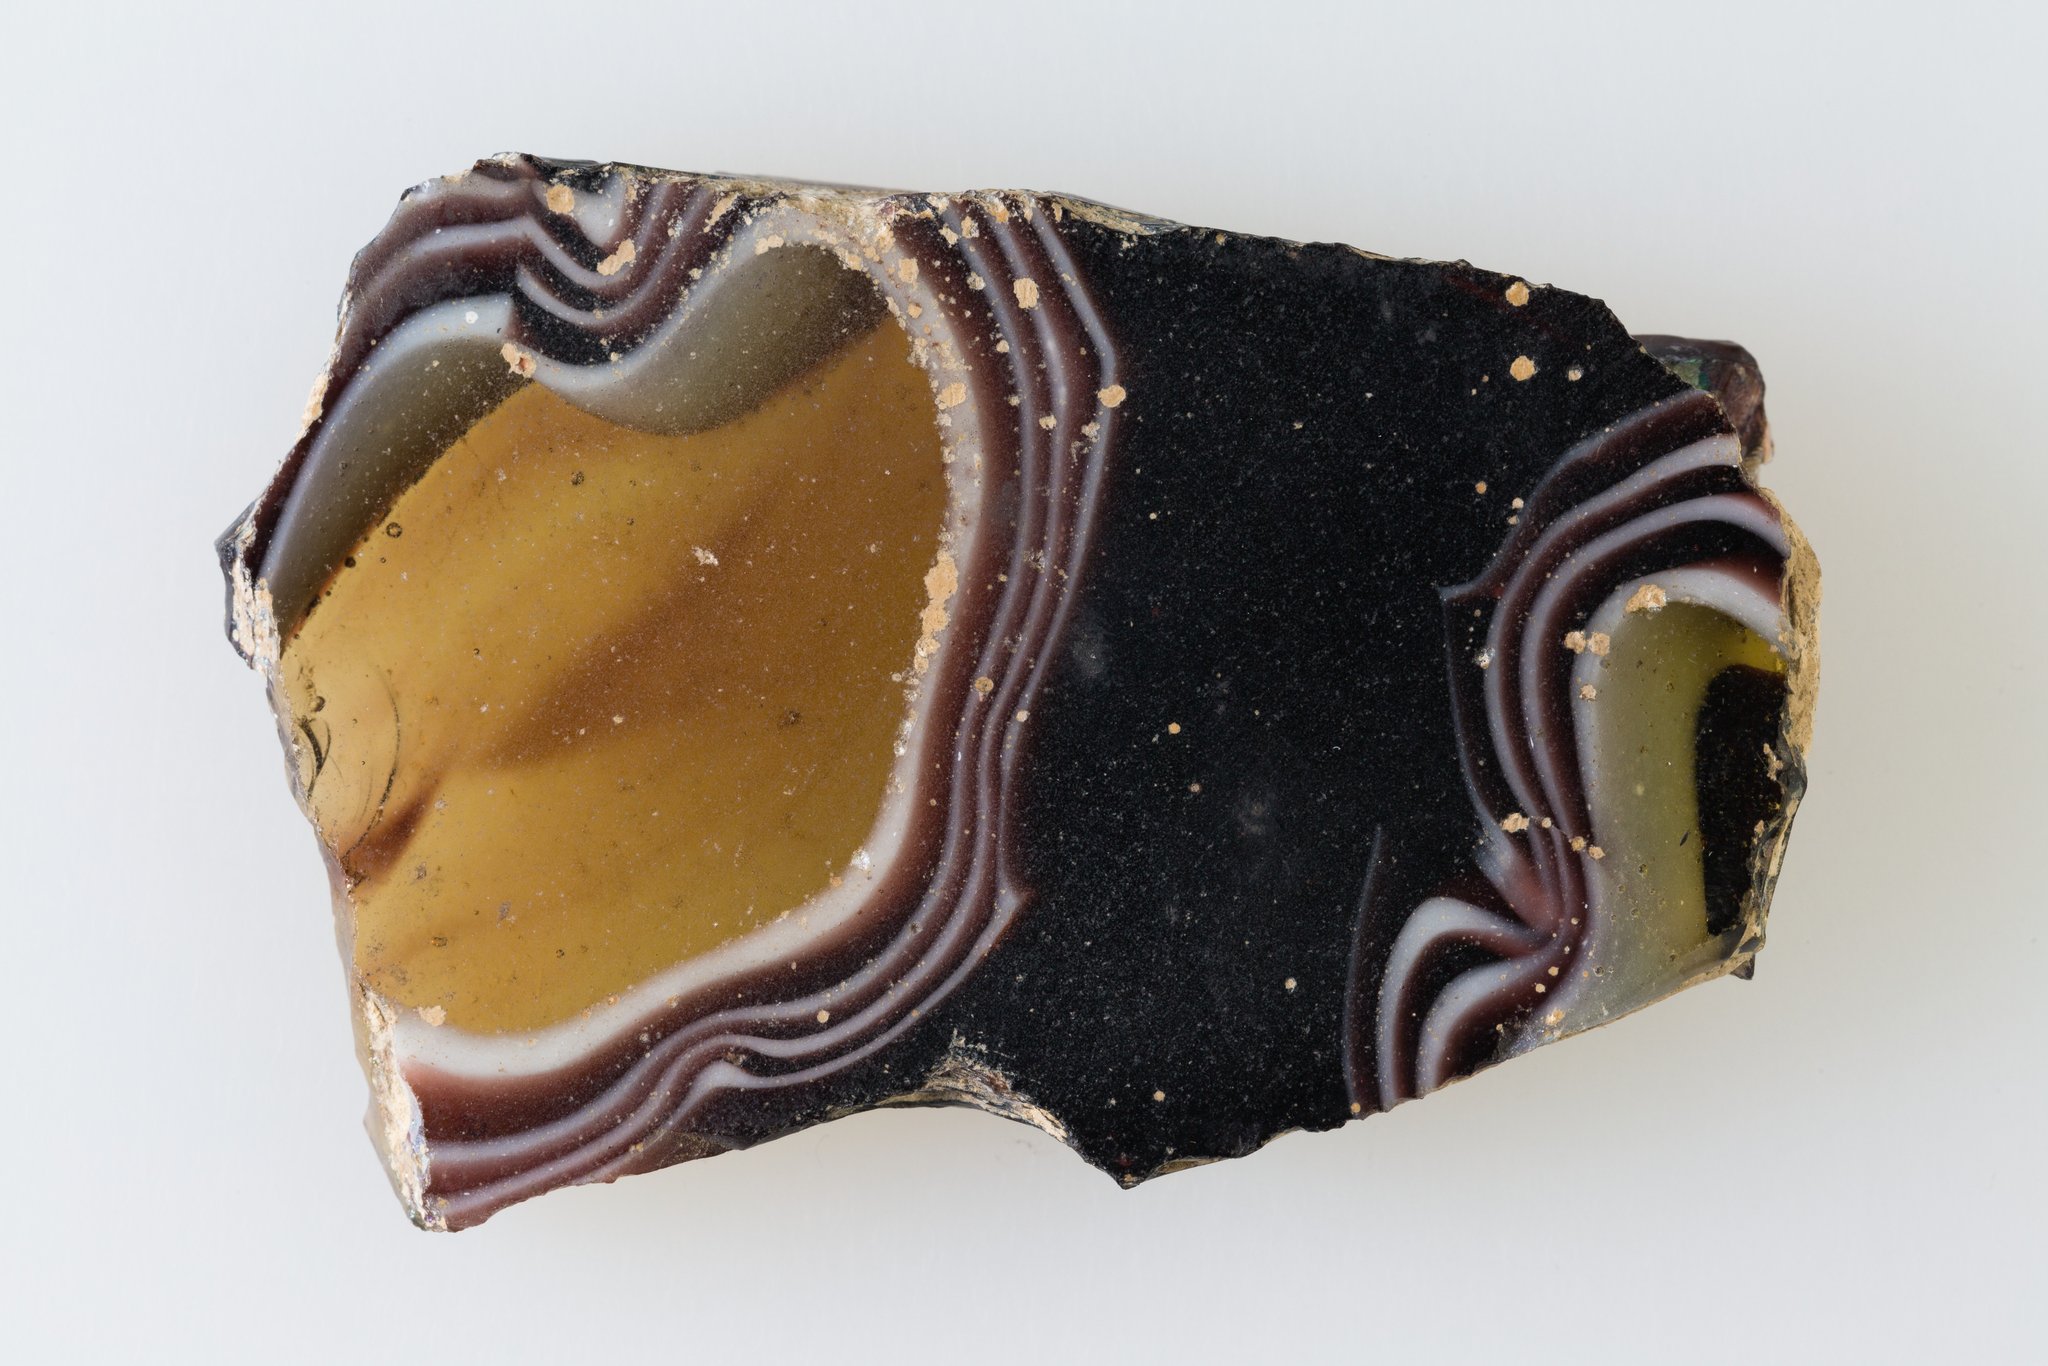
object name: wall revetment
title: Wall revetment, agate pattern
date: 200 BCE-100 CE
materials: glass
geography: egypt